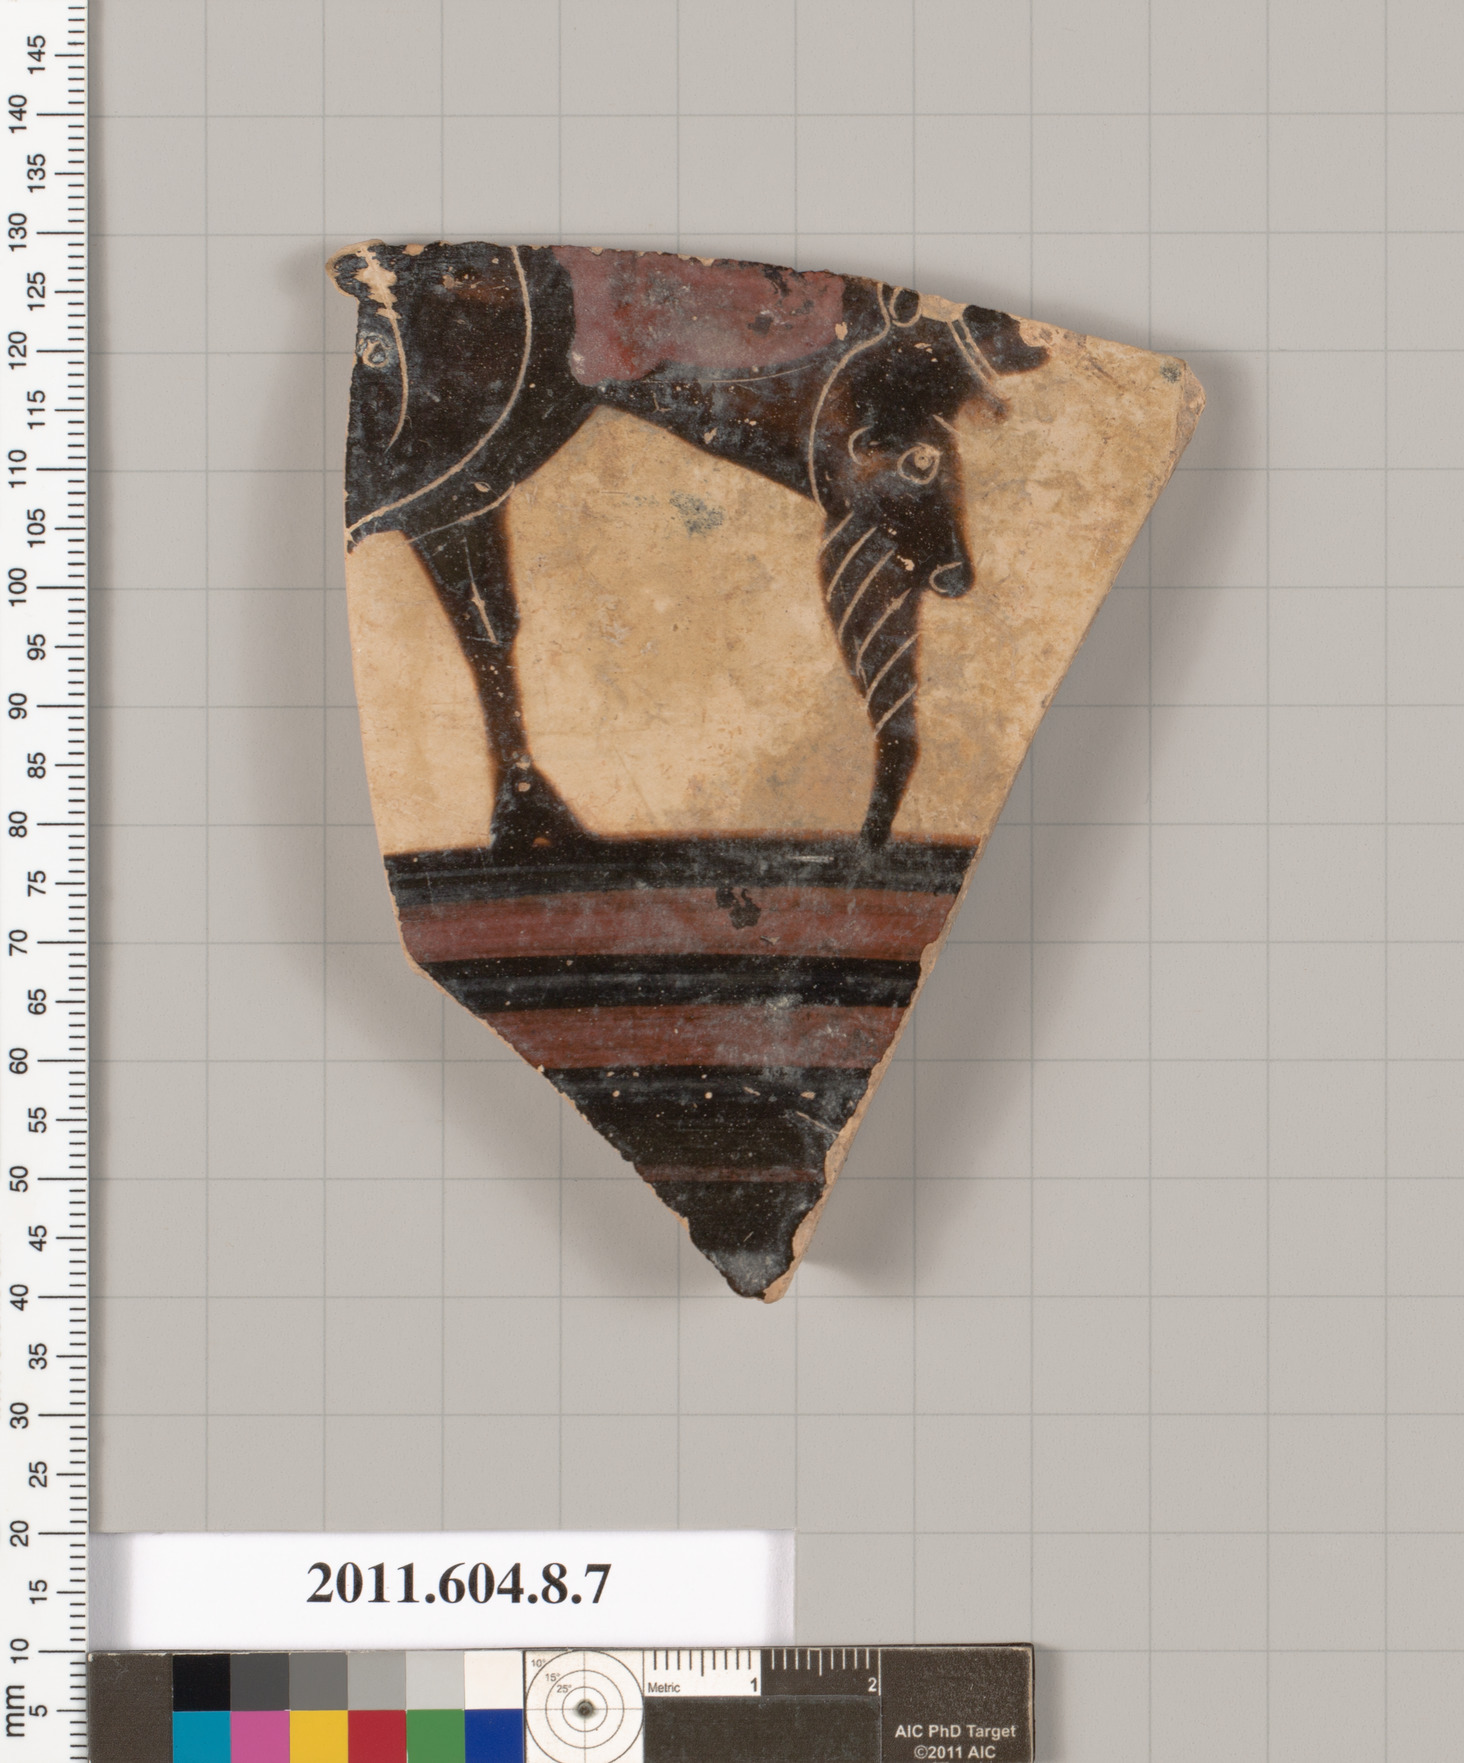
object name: krater fragment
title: Terracotta fragment of a krater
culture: greek, corinthian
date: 550-501 BCE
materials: terracotta